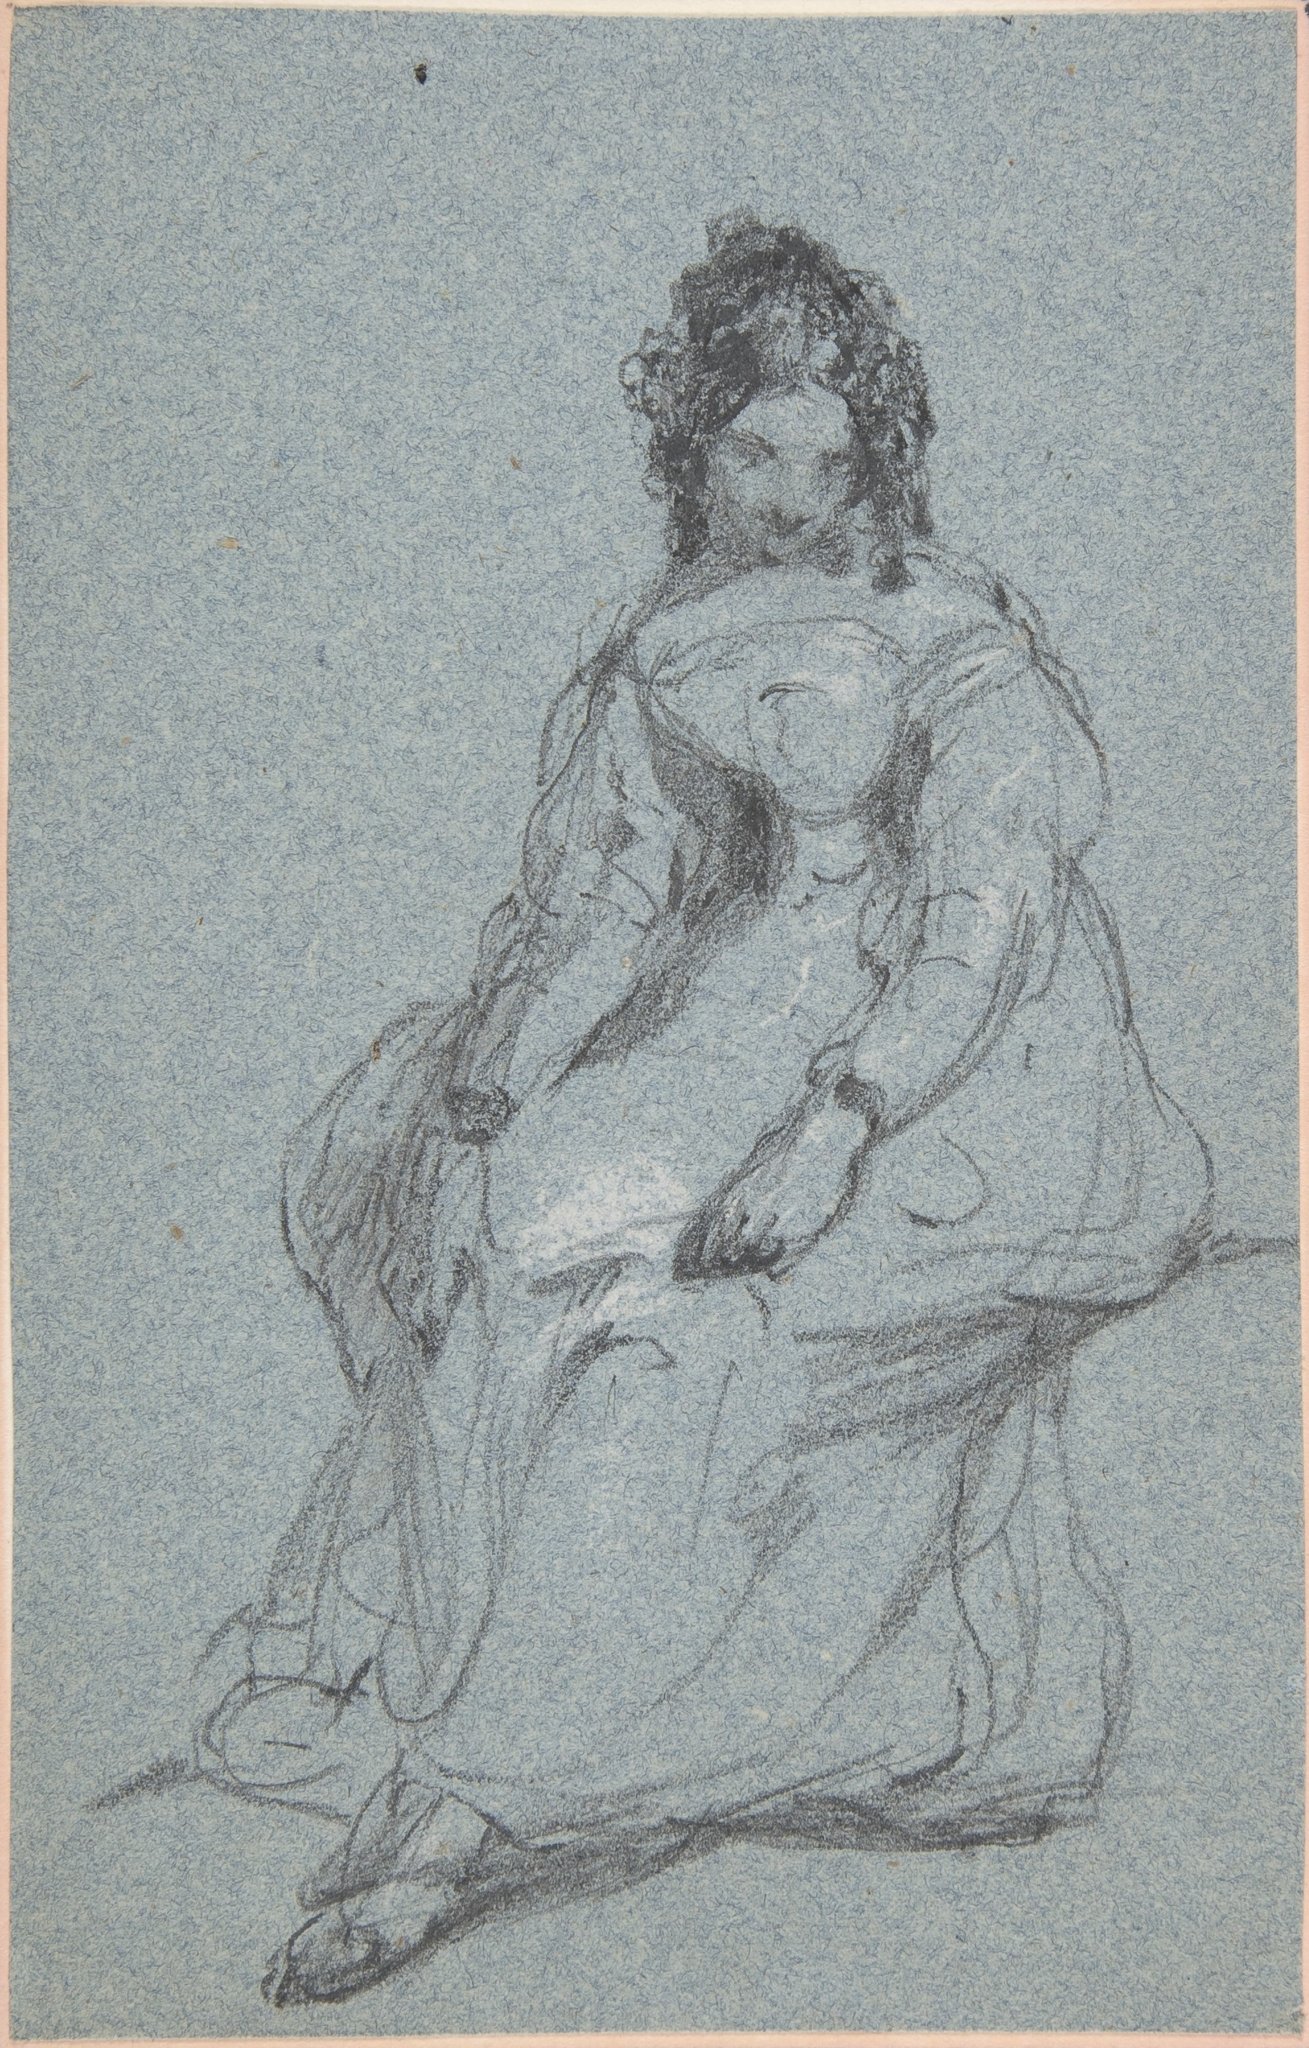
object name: drawing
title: Seated girl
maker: george jones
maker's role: artist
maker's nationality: british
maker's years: 1786-1869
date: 1820-1840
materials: chalk, paper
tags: girls